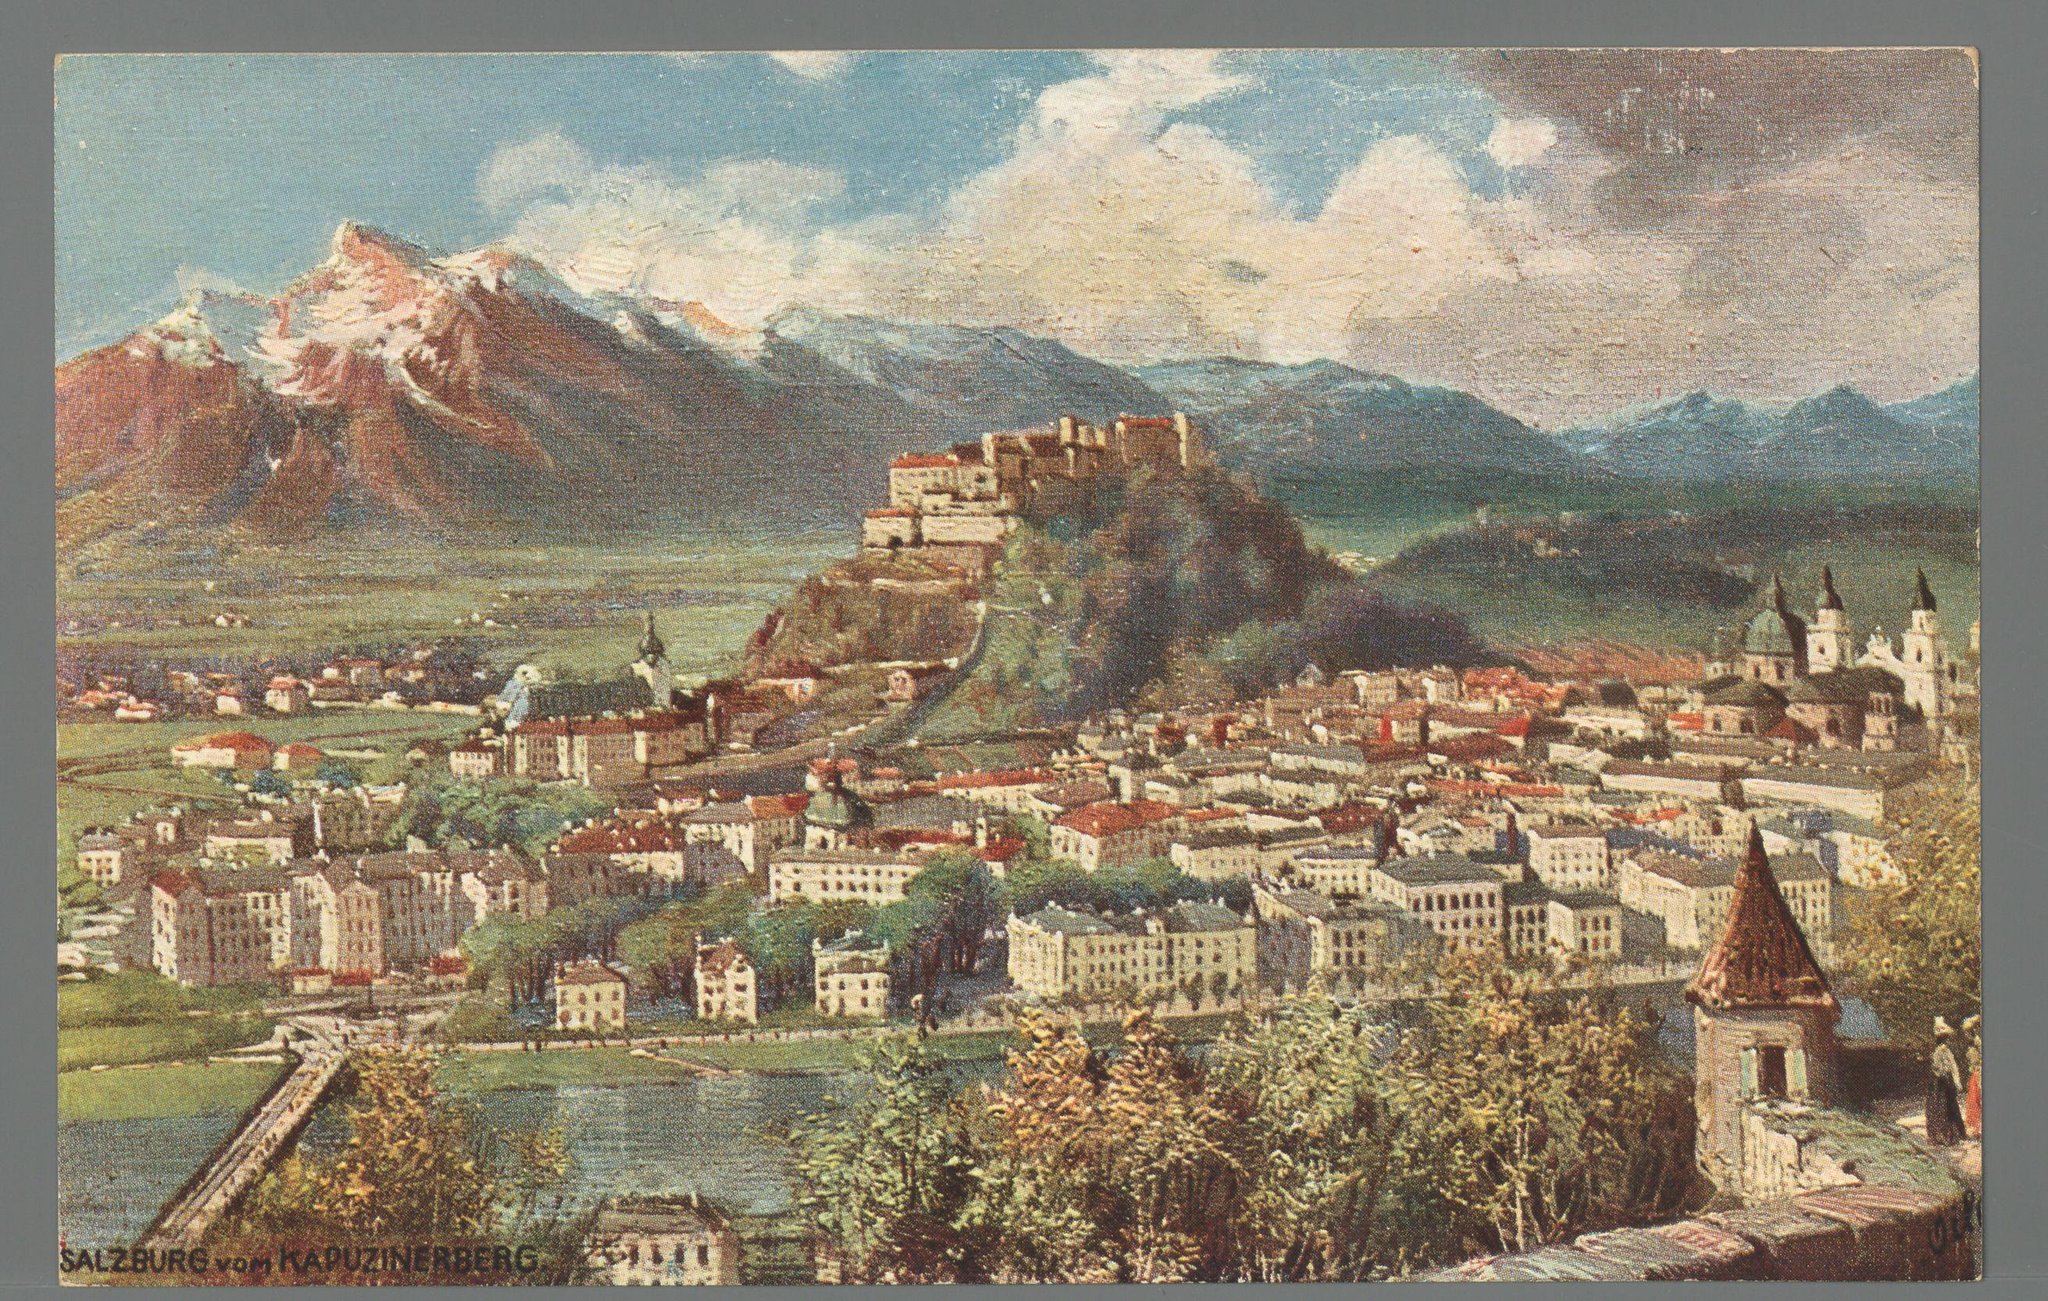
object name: ansichtkaart, prentbriefkaart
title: Oilette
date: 1904-1909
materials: cardboard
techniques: writing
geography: london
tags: city-view, and landscape with man-made constructions, castle, canals, waters (in city), bridge in city across river, canal, etc.